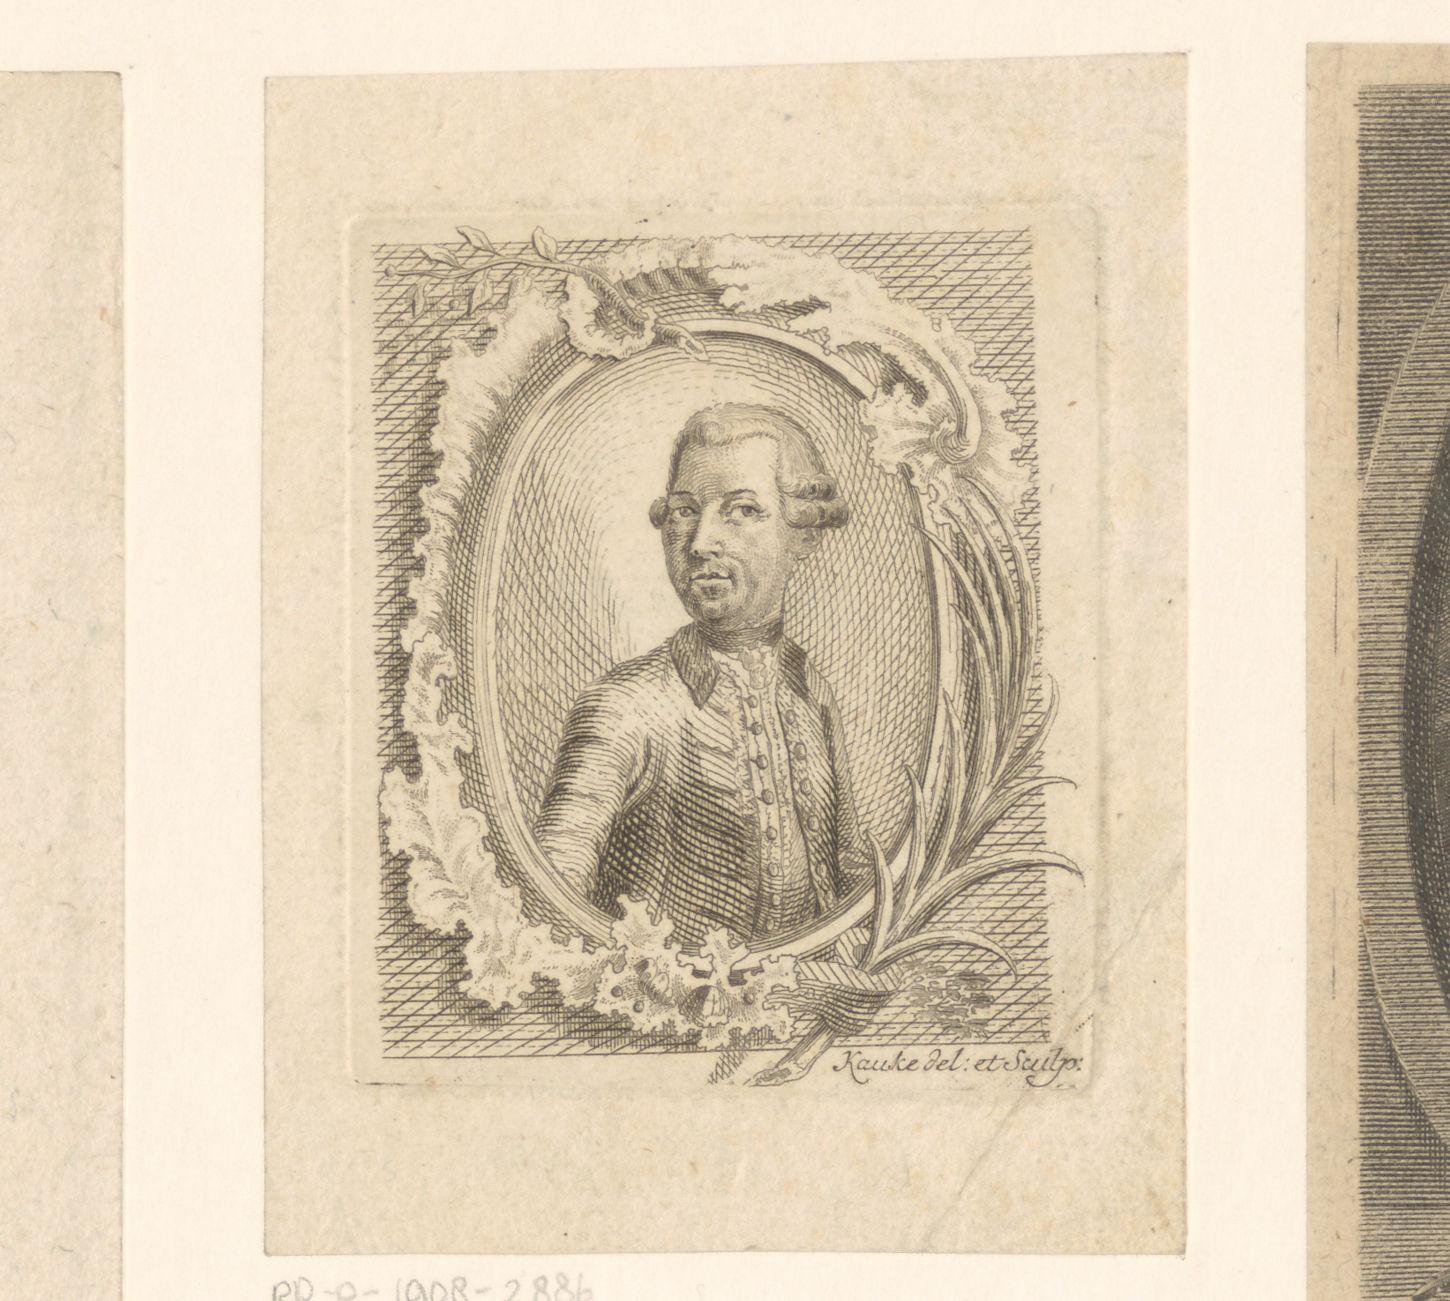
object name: print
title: Portret van een onbekende man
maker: friedrich johann kauke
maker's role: print maker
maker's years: -1777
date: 1677-1777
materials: paper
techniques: etching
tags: ornament ~ medallion, anonymous historical person portrayed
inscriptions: collector's mark: Lugt 2228